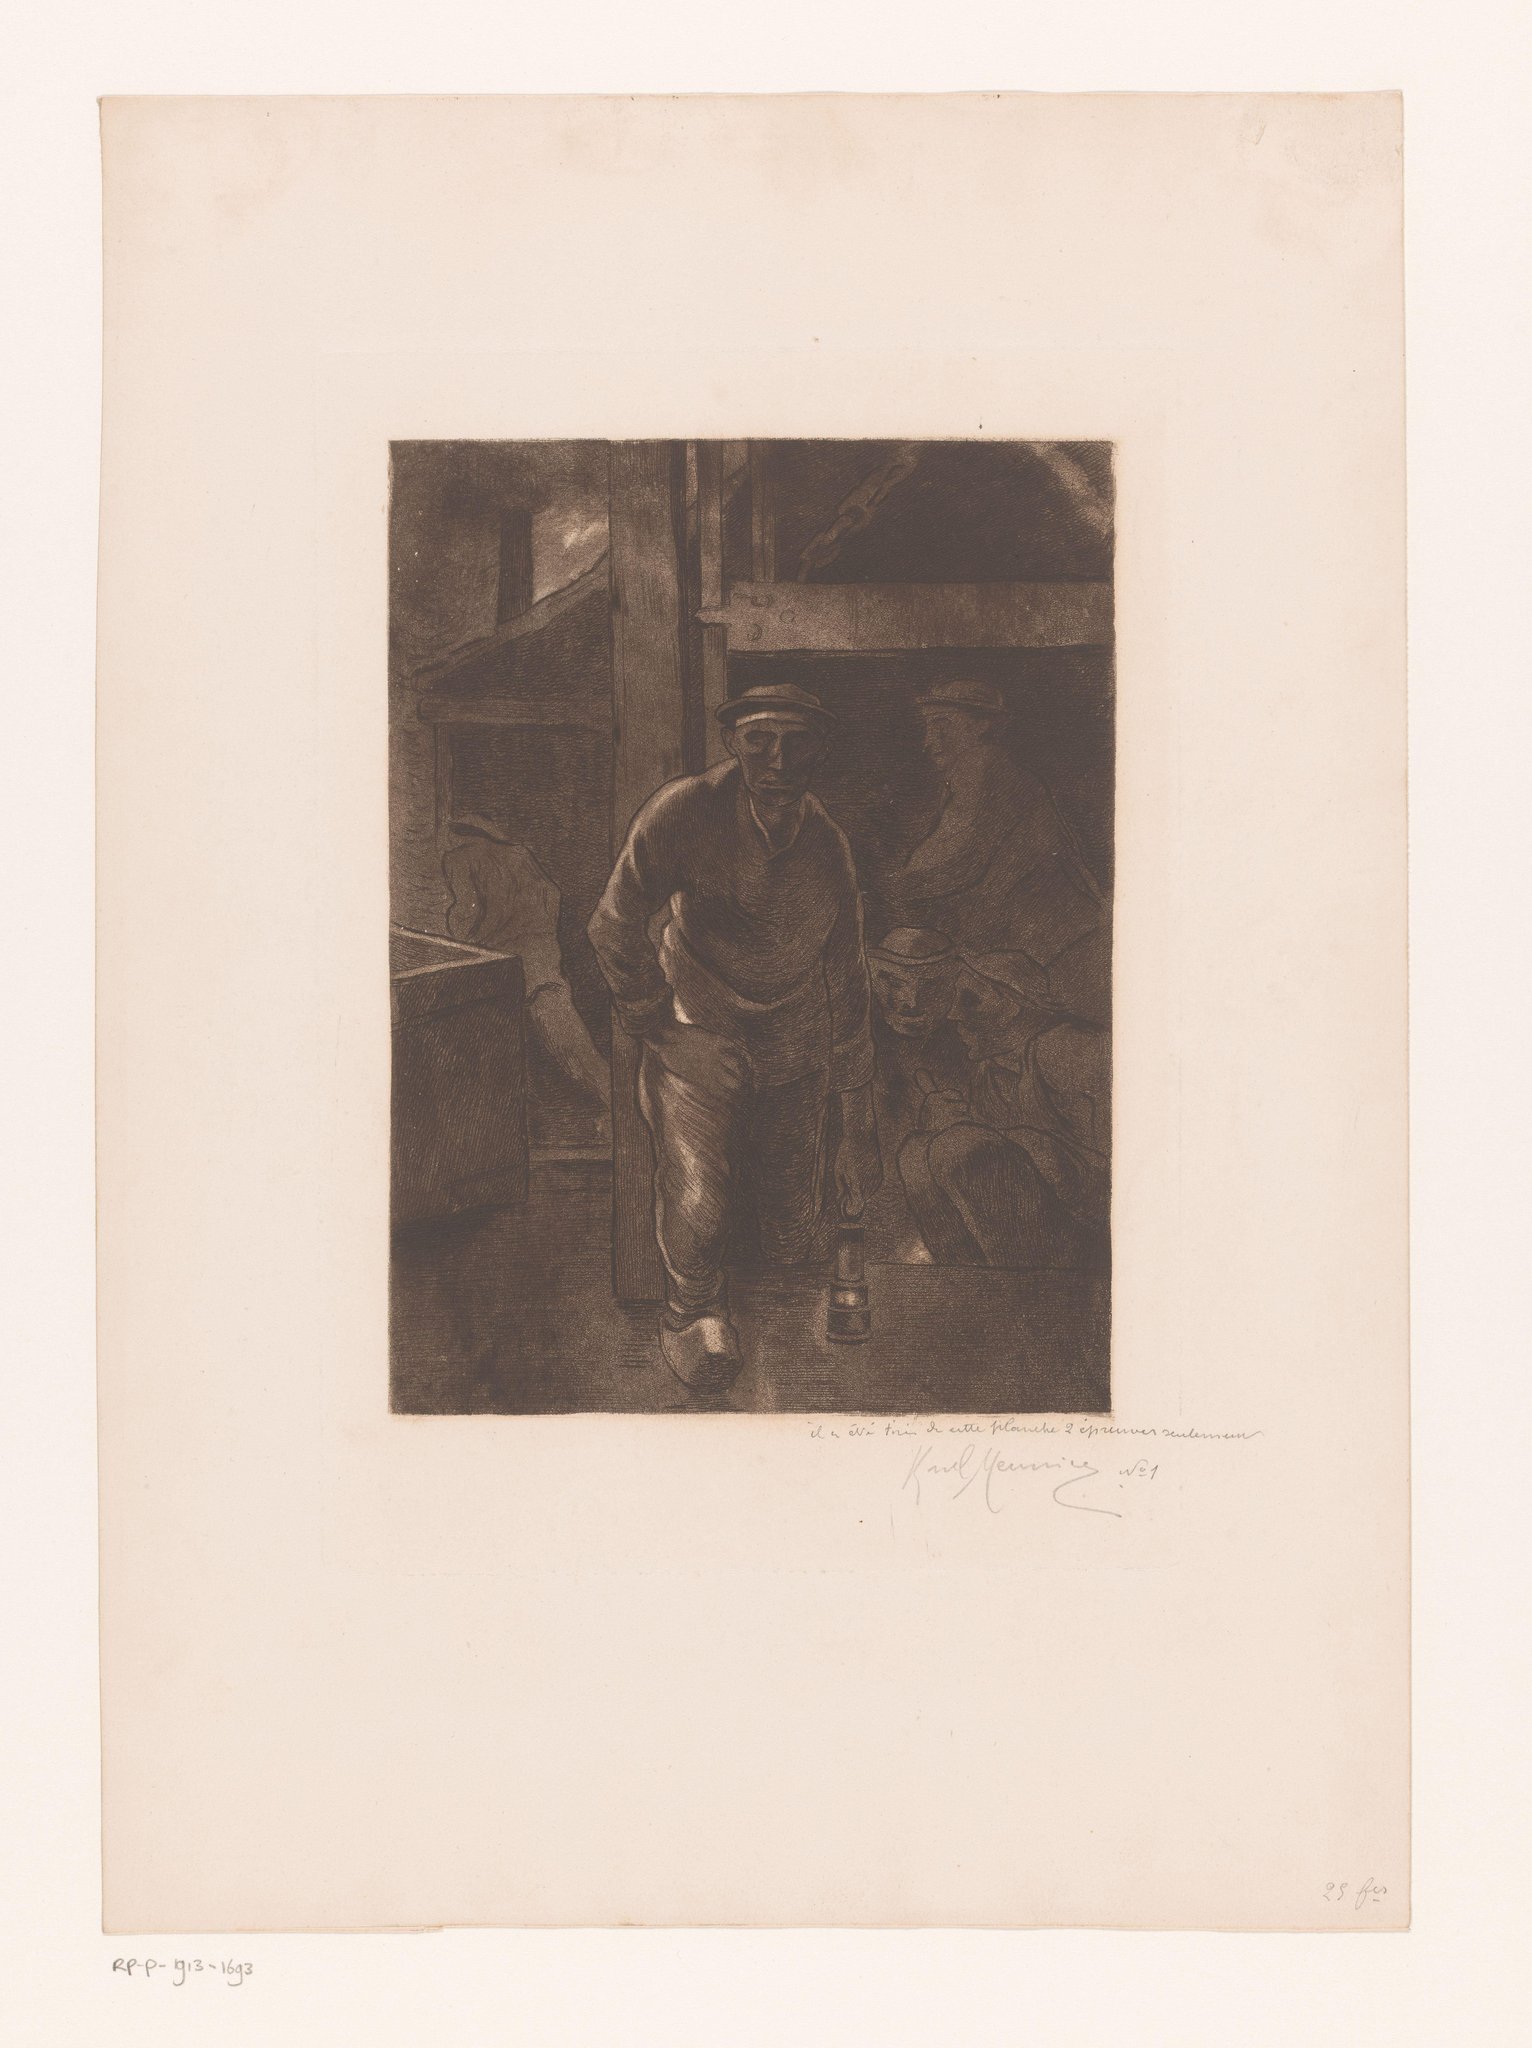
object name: print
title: Mijnwerkers komen terug uit de mijn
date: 1874-1894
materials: paper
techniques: etching, intaglio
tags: miner, shafts and galleries (of a mine), lantern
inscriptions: collector's mark: Lugt 2228, inscription: ‘Il a été tire de cette [plouche] 2 épreuves seulement; No 1’